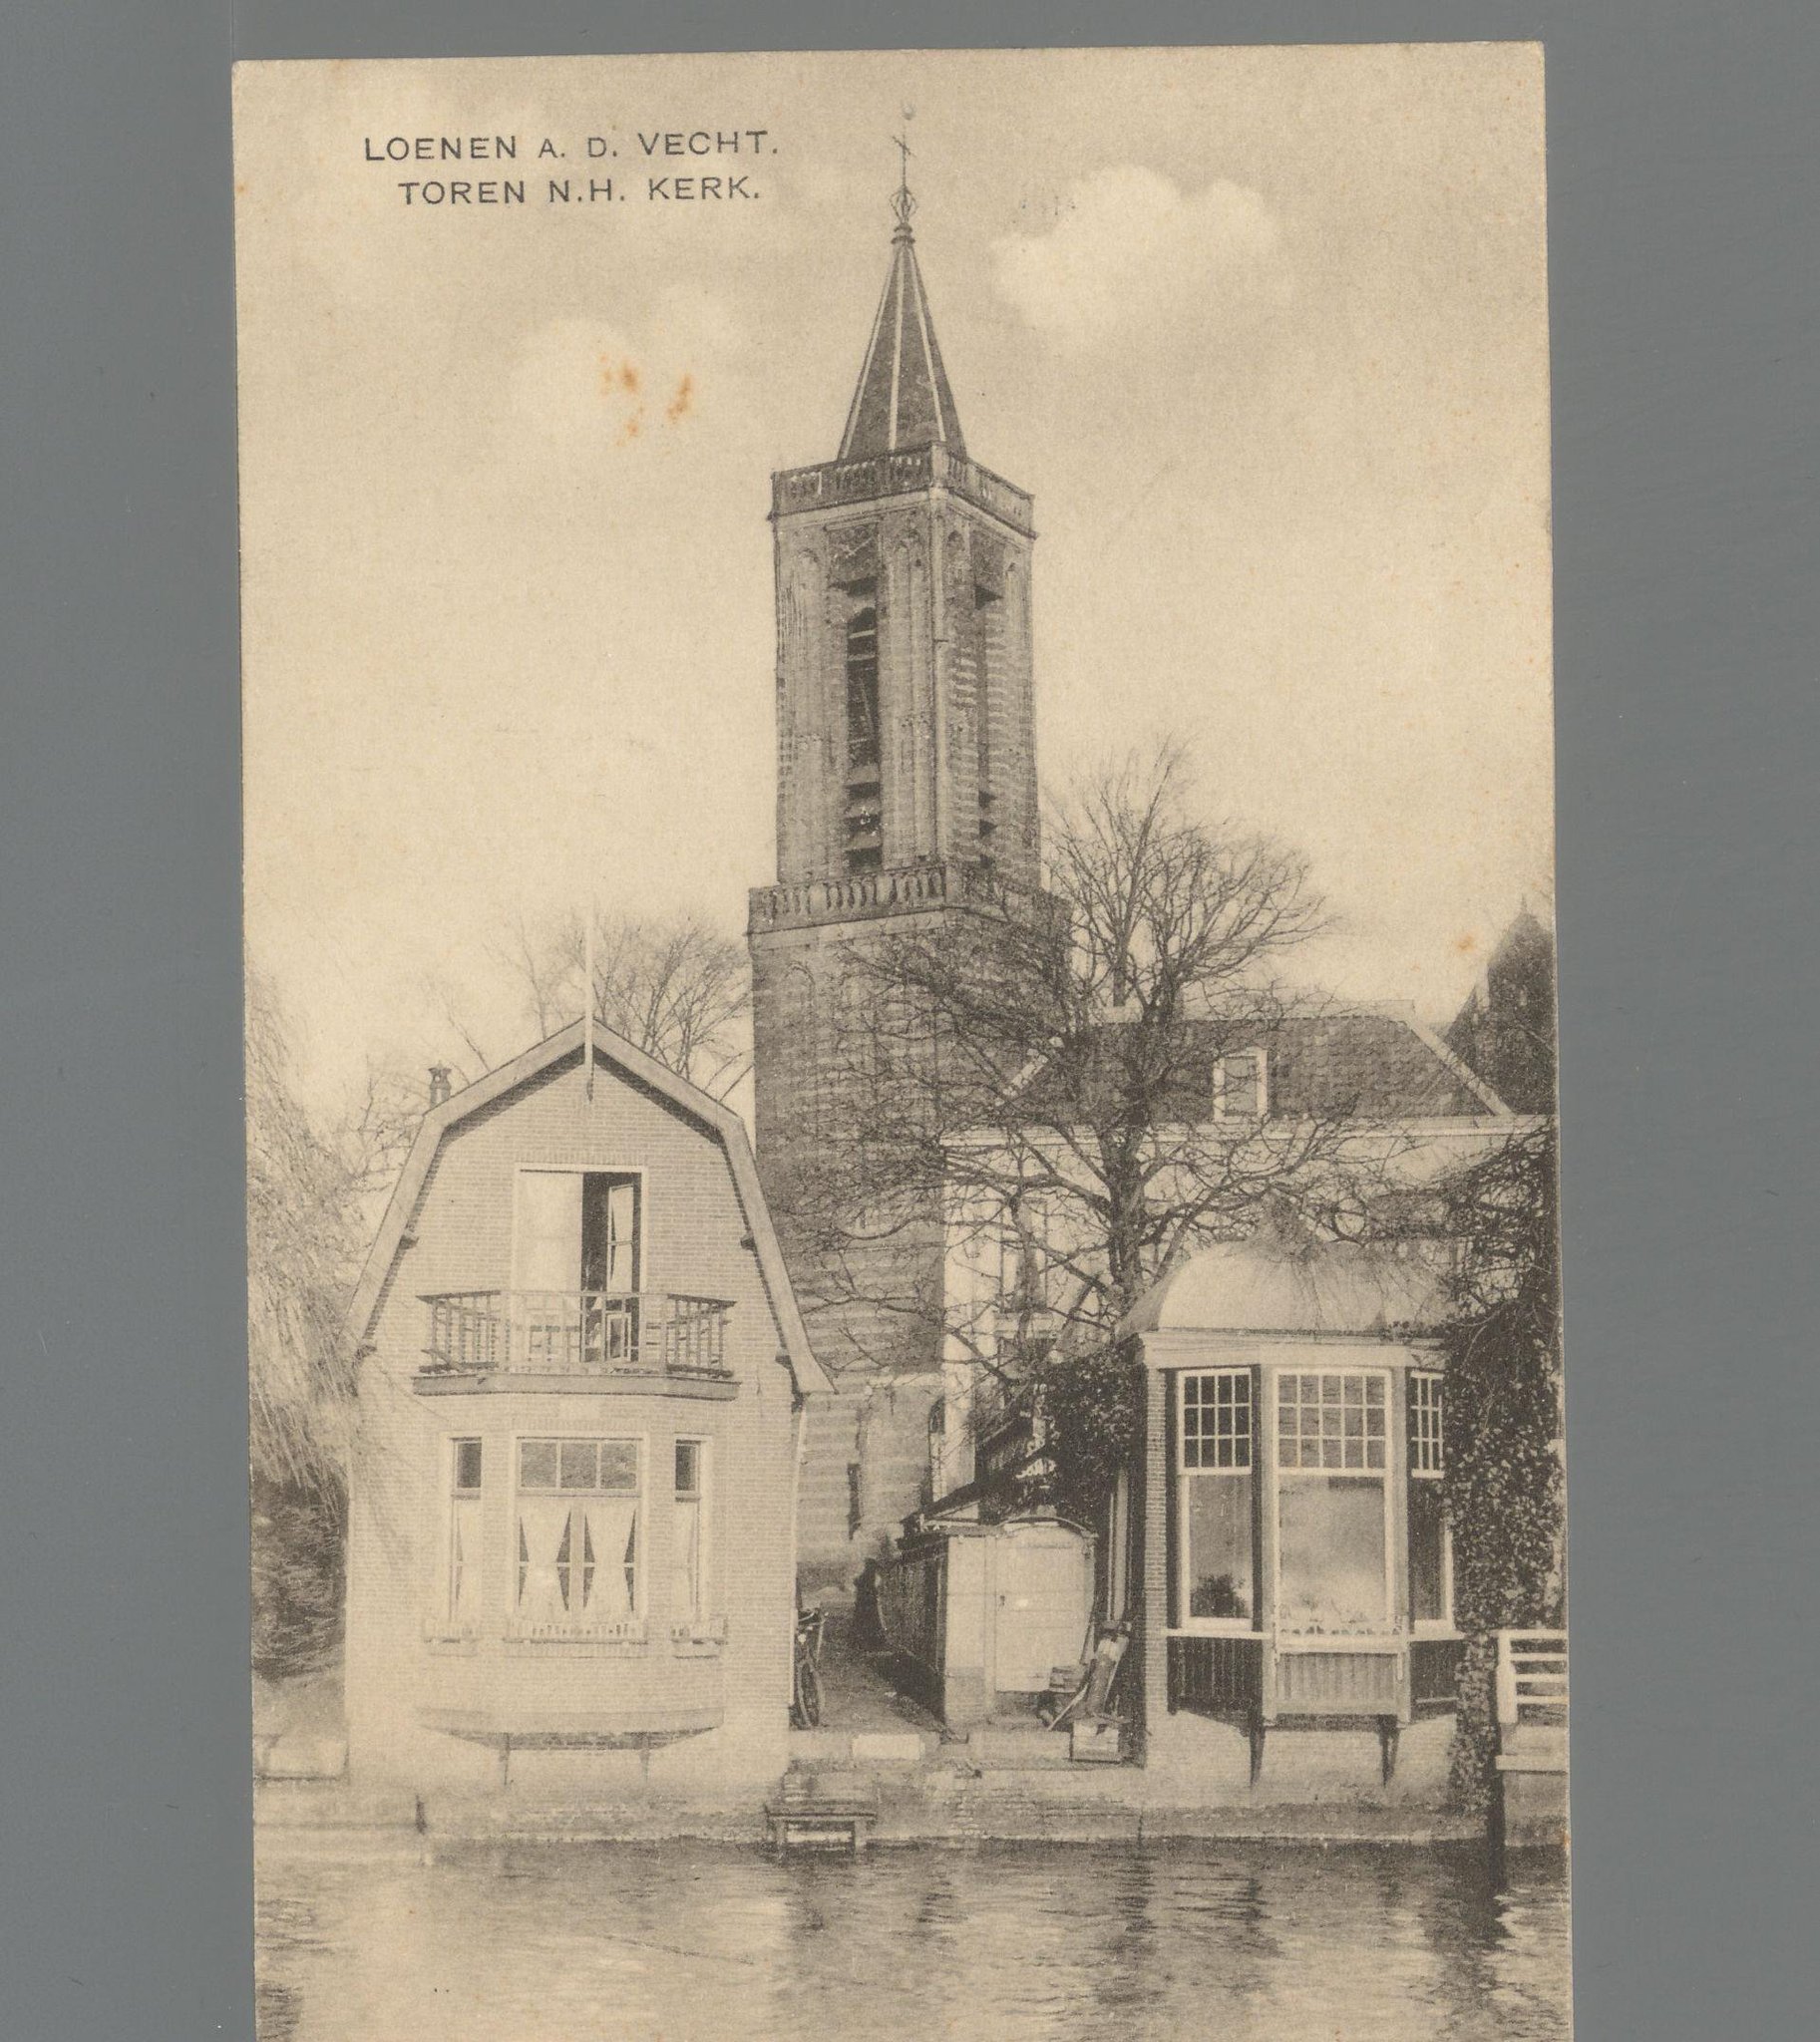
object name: photomechanical print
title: Loenen a. d. Vecht. Toren N.H. Kerk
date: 1905-1927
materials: cardboard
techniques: photograph, writing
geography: loenen aan de vecht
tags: river, church (exterior), vecht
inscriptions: poststempel, verso, gestempeld